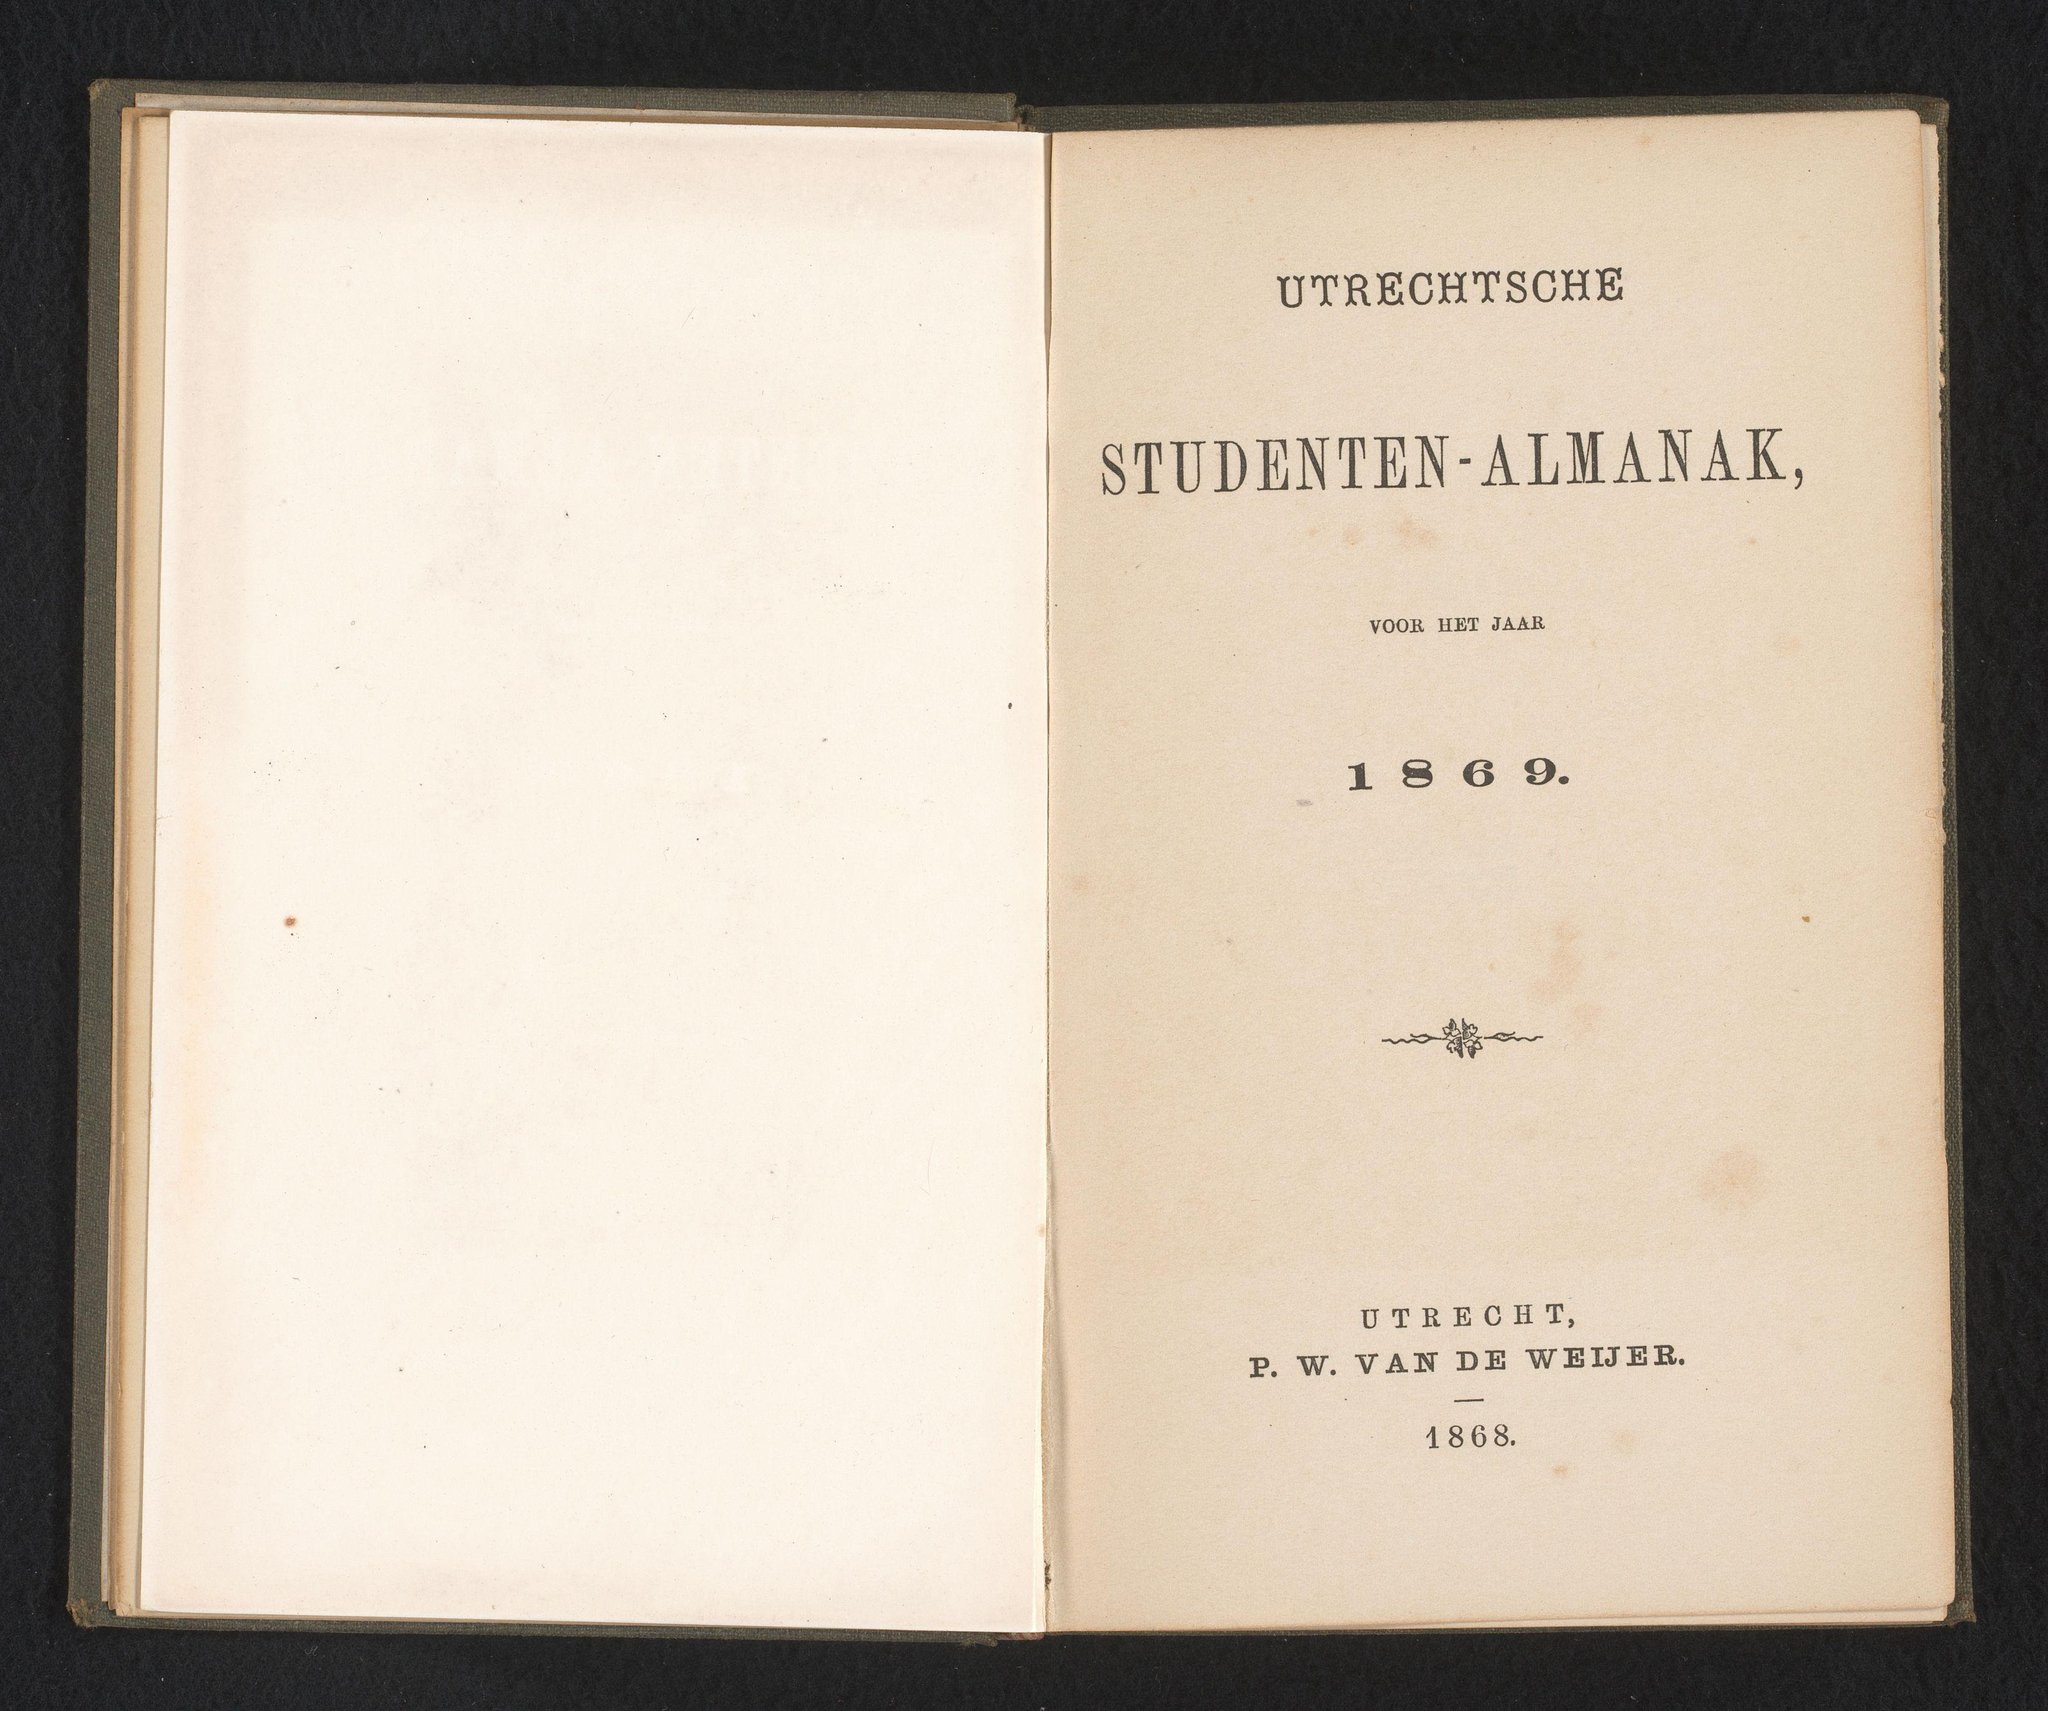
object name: book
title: Utrechtsche studenten-almanak voor het jaar 1869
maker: pieter wilhelmus van de weijer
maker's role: print maker, printer, publisher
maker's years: 1816-1880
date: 1868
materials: paper, cardboard, leather, linen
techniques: letterpress printing, lithograph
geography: utrecht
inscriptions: number: ‘4831/1’, inscription: ‘gekocht dec. 1964 f2,50/ Kok Amsterdam’